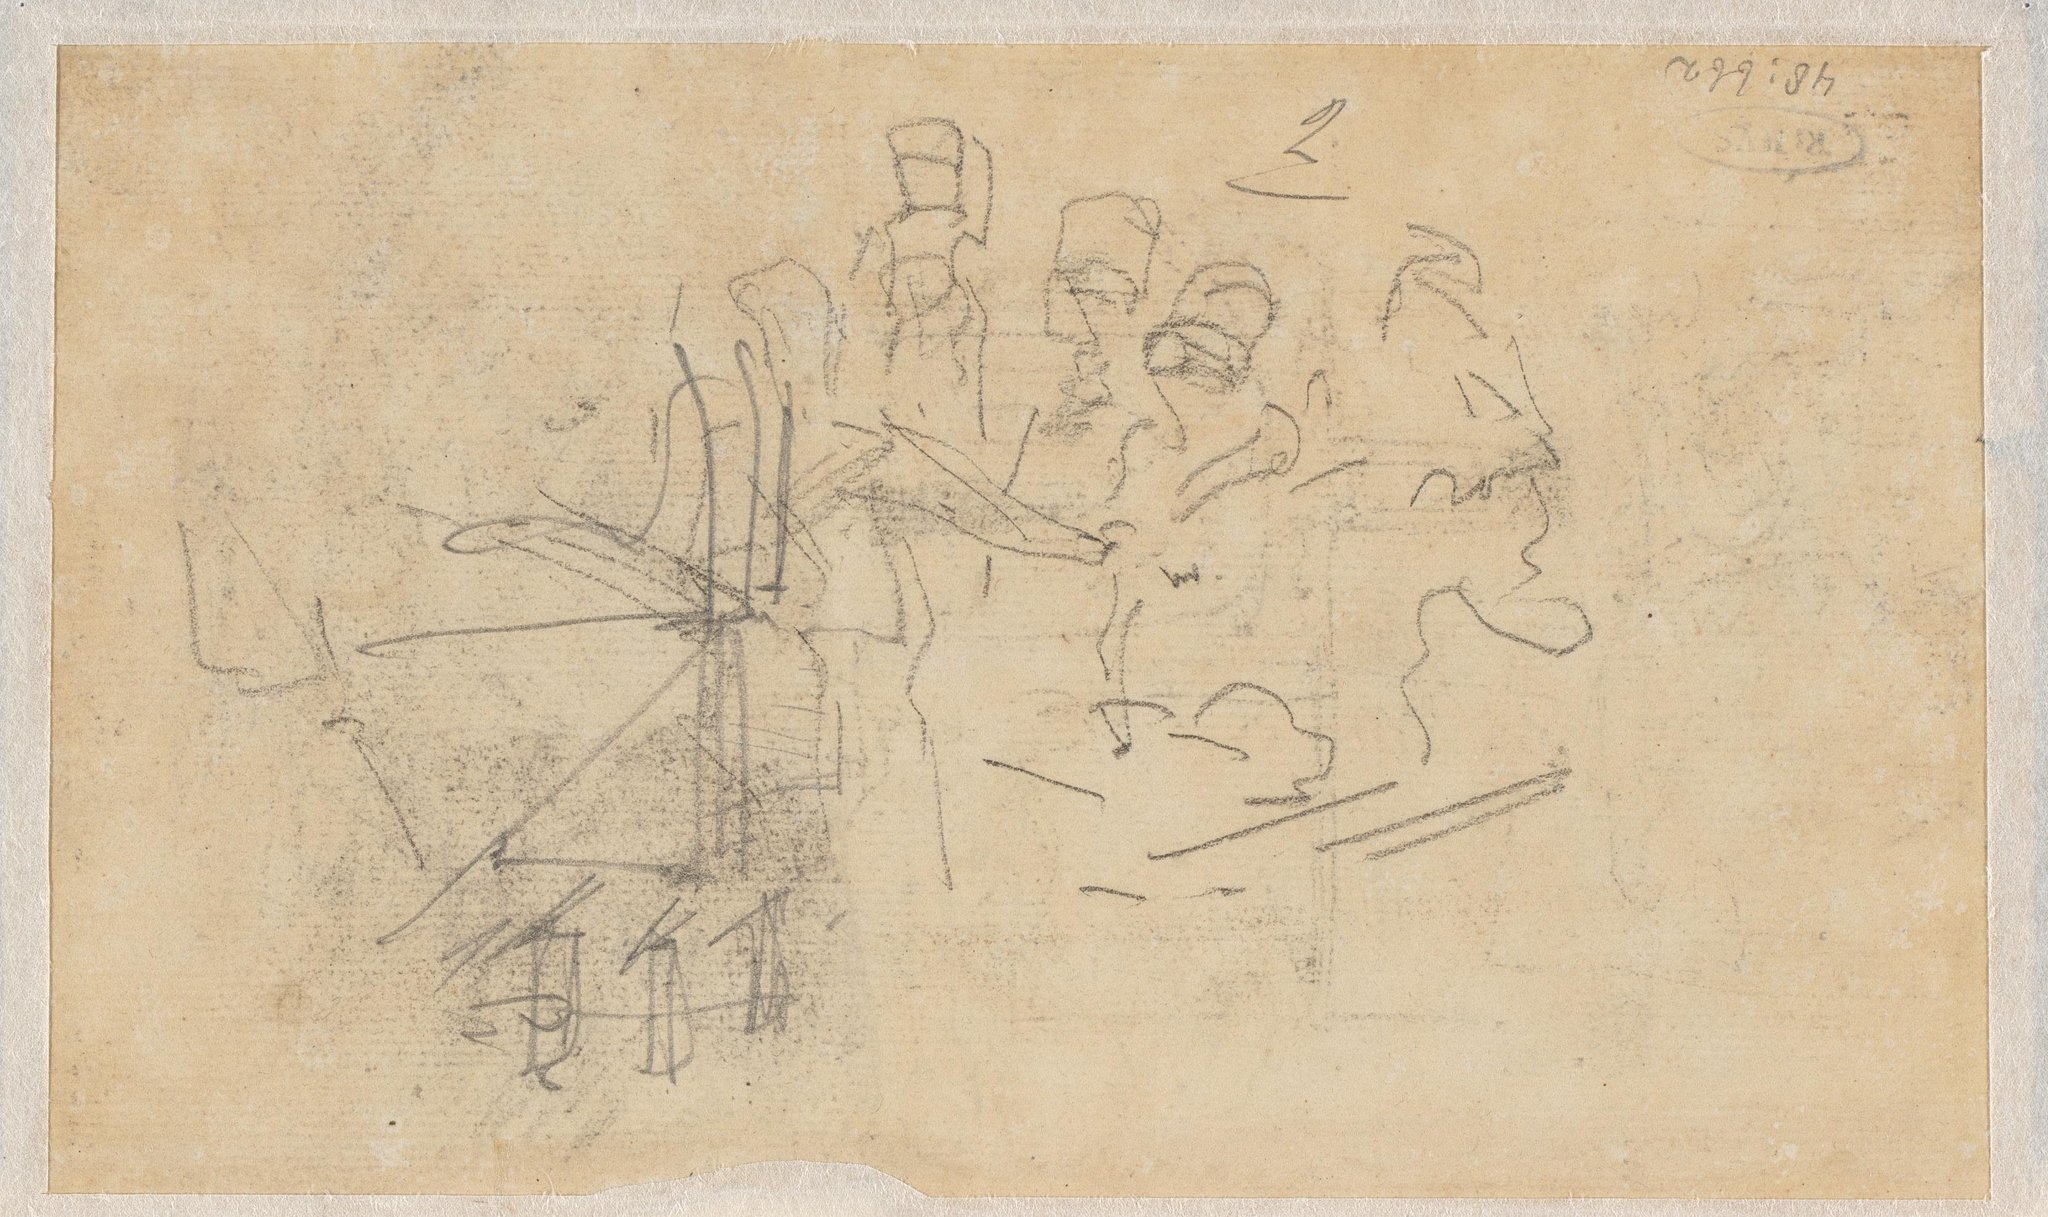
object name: drawing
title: Schets met huizen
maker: george hendrik breitner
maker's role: draughtsman, painter, print maker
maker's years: 1857-1923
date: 1867-1923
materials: chalk, paper, pencil